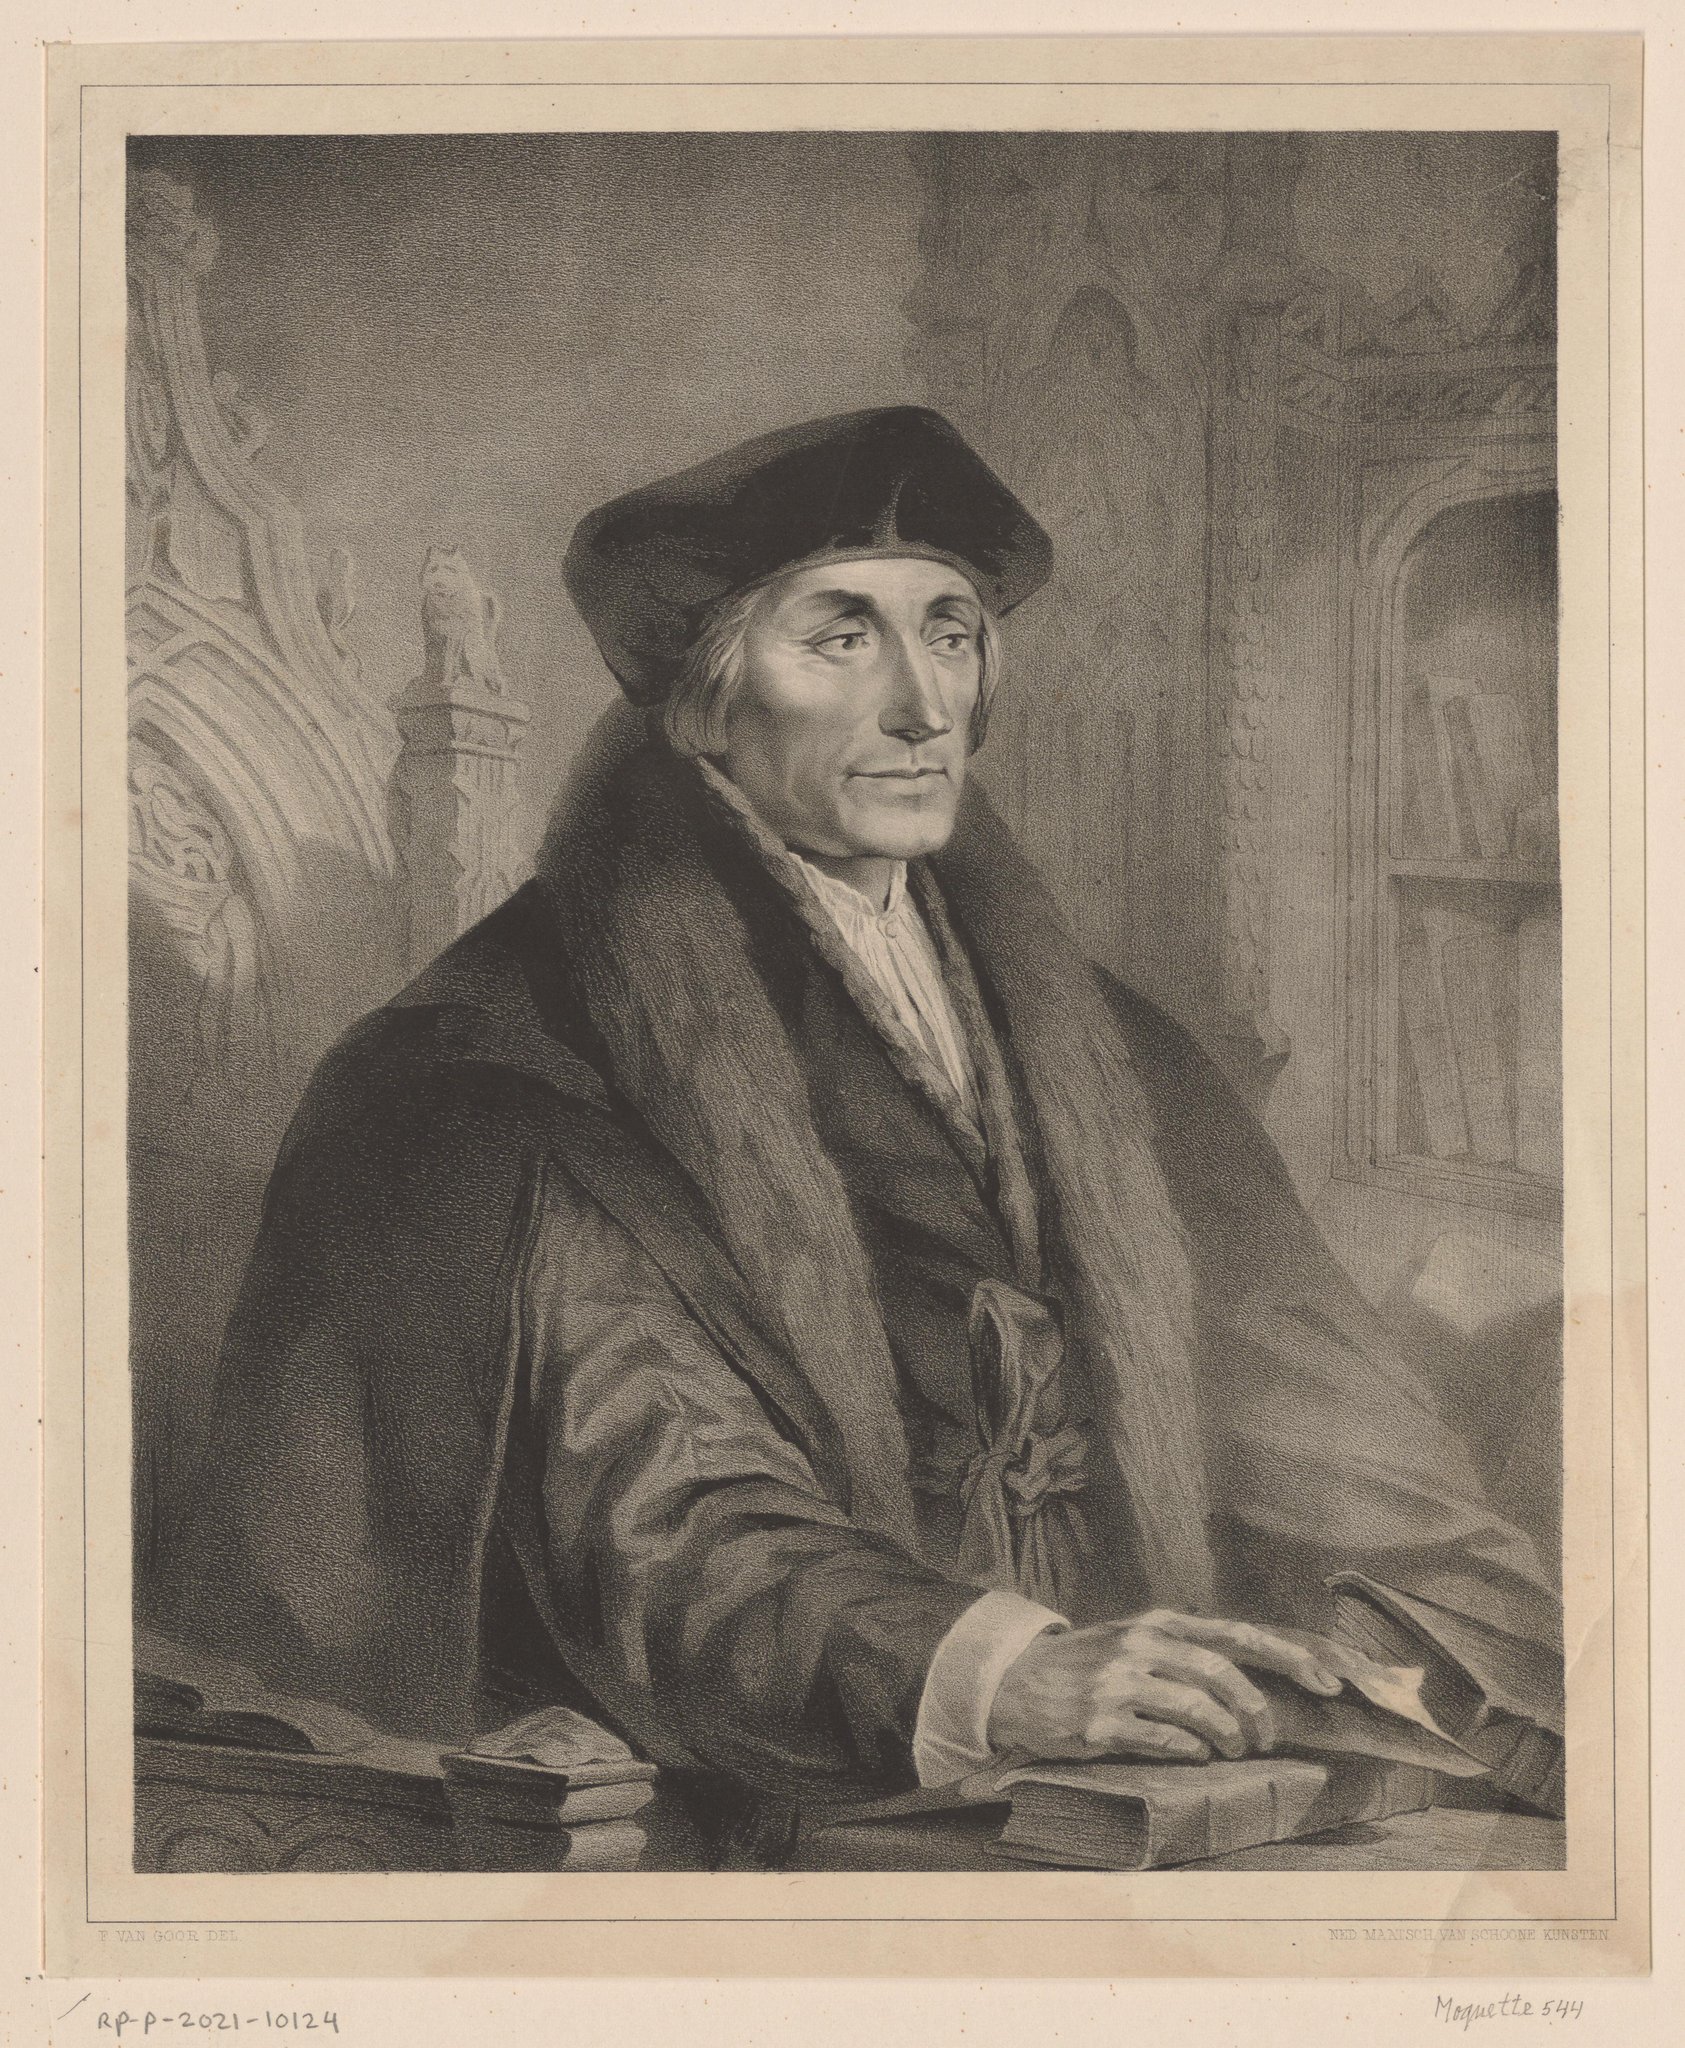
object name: print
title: Portret van Desiderius Erasmus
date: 1840-1843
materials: paper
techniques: lithograph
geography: the hague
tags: rotterdam, desiderius erasmus, historical persons, book, scholar, philosopher (+ portrait of scholar, scientist)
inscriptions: collector's mark: Lugt 2228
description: Prent komt mogelijk uit een editie van de 'Kunstkronijk'.